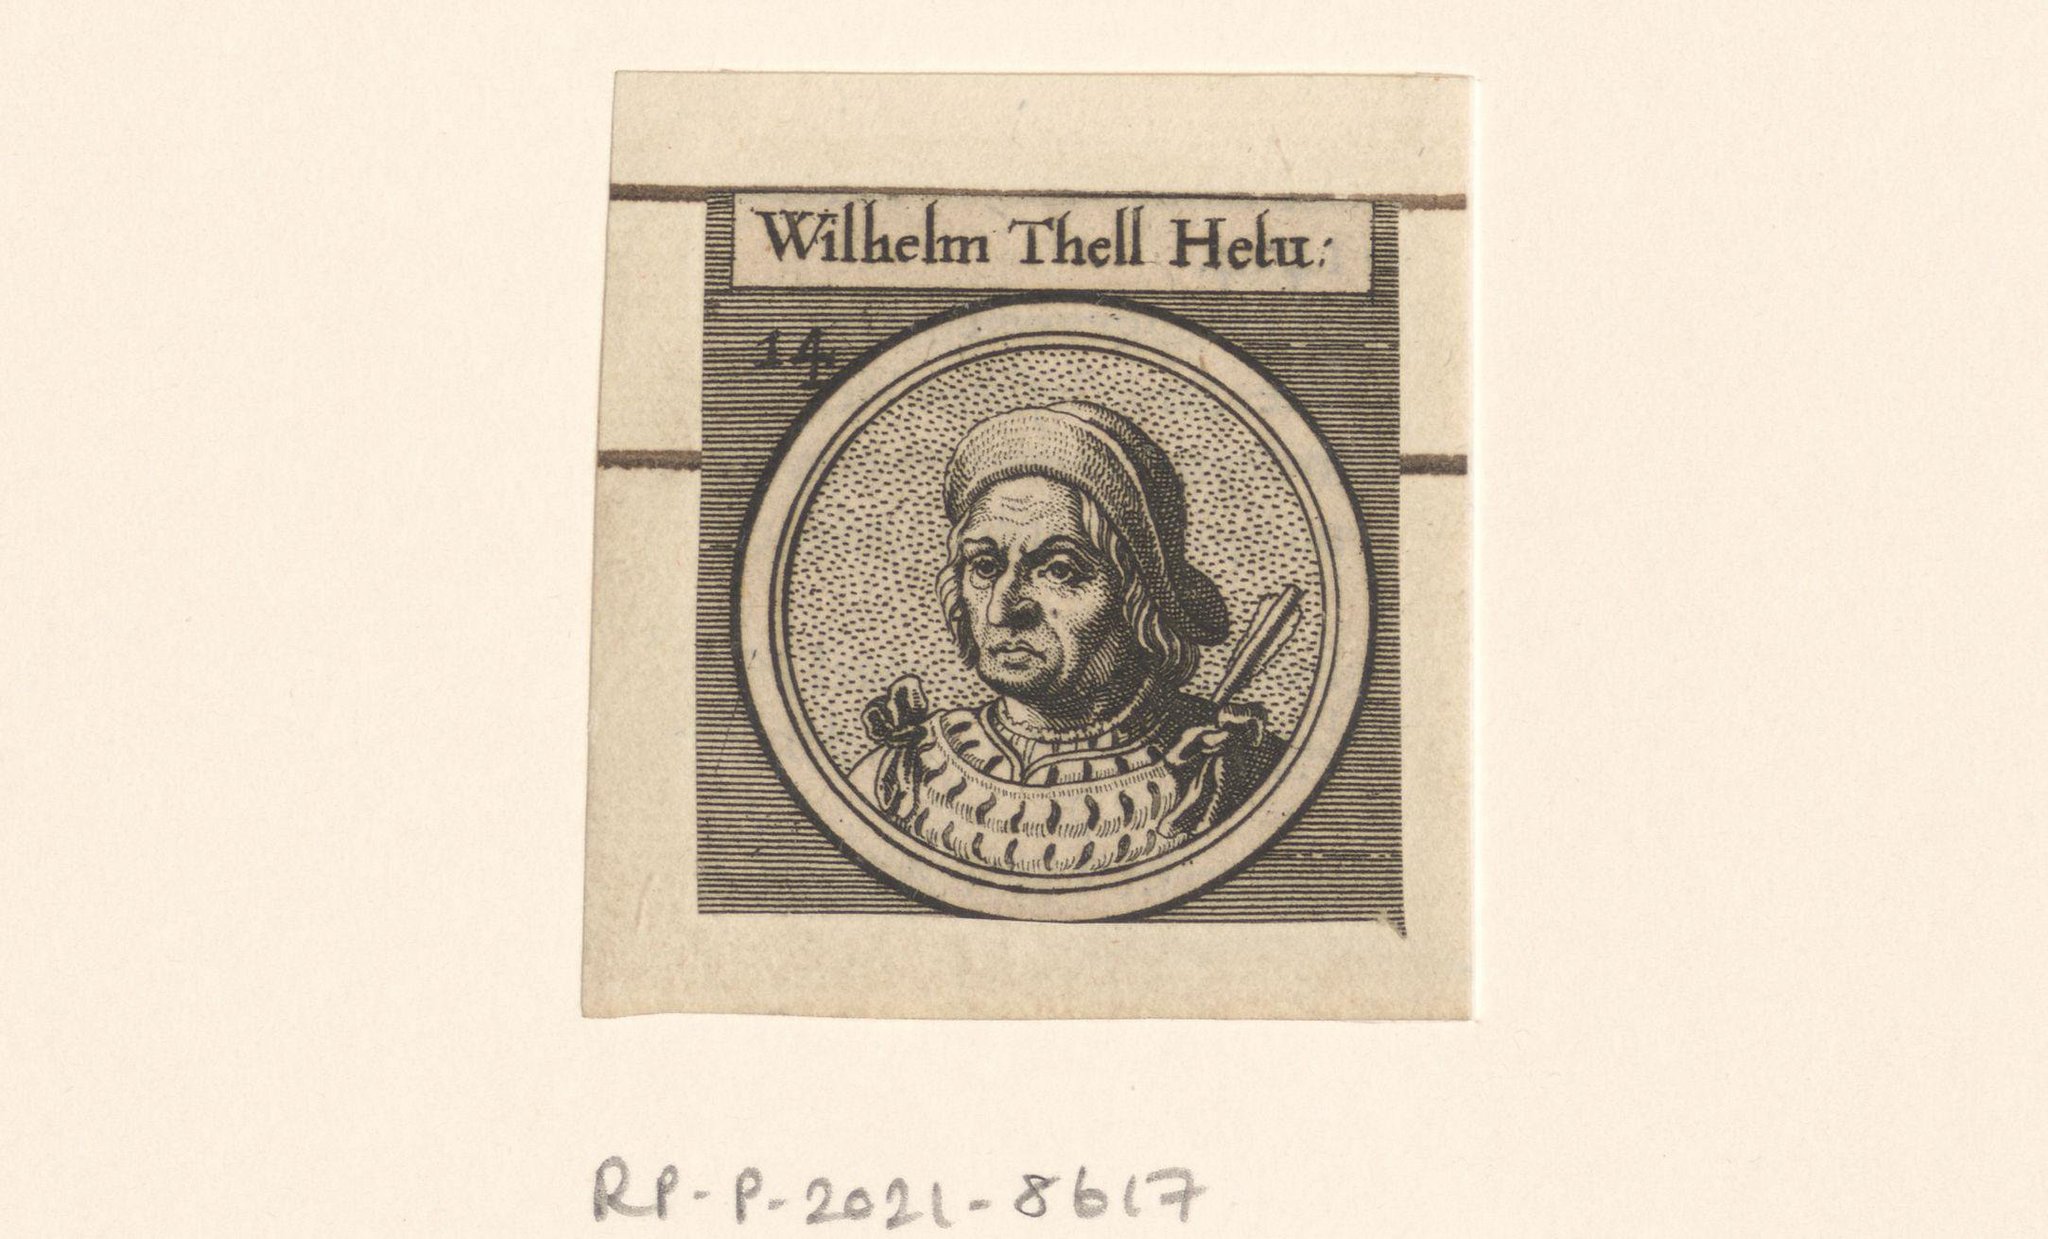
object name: book illustration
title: Portret van William Tell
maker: Anonymous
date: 1660-1698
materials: paper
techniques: etching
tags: historical persons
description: Prent gebruikt in: Gottfried, Johann Ludwig. Historische chronyck, vervattende de gedenkwaardighste geschiedenissen (...). Amsterdam: Johannes Brouwer en Jacob van Meurs, 1660. Prent ook gebruikt in de 1698-editie van dit werk.